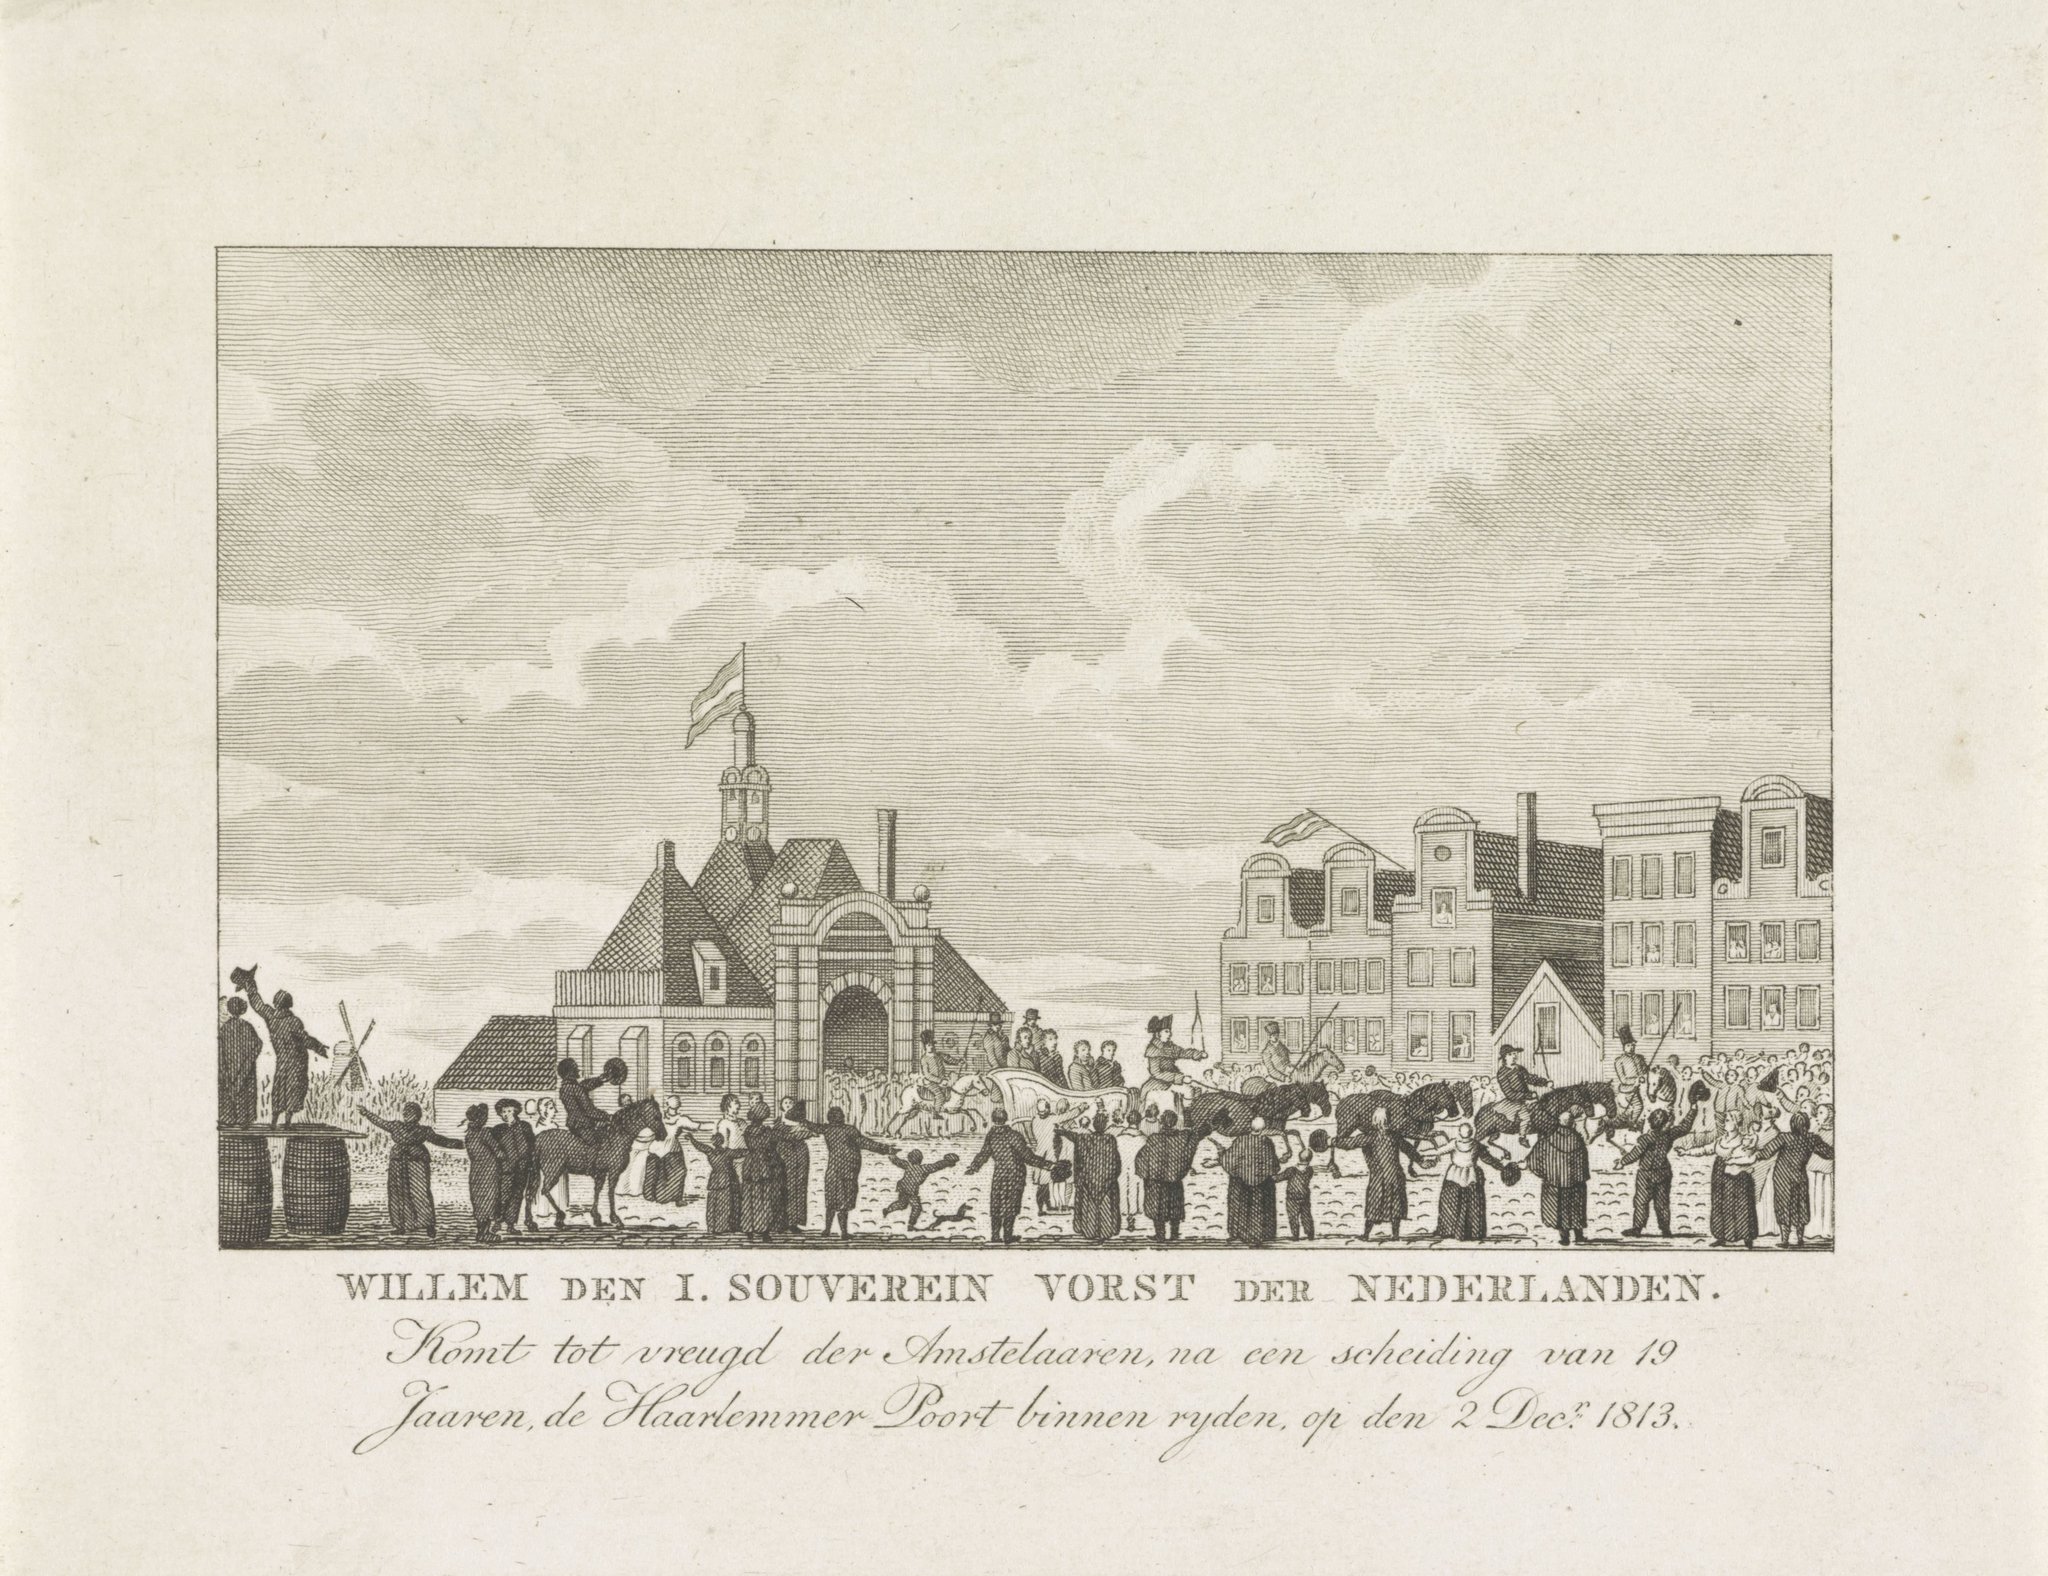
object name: print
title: Intocht van prins Willem Frederik te Amsterdam, 1813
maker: Anonymous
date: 1813-1814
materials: paper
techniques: etching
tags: the hague, william i of the netherlands, public festivities at other royal events, not meant or mentioned above, triumphal entry and public reception, pageant, 'entrée solennelle', 'joyeuse entrée', amsterdam, landing of william frederick i (1813)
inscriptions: collector's mark: Lugt 2228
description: Intocht van prins Willem Frederik als Souverein Vorst te Amsterdam op 2 december 1813. De stoet met het rijtug met de prins rijdt door de Haarlemmerpoort de stad binnen. Langs de kant van weg juichende toeschouwers. Onder de titel een tweeregelig vers.